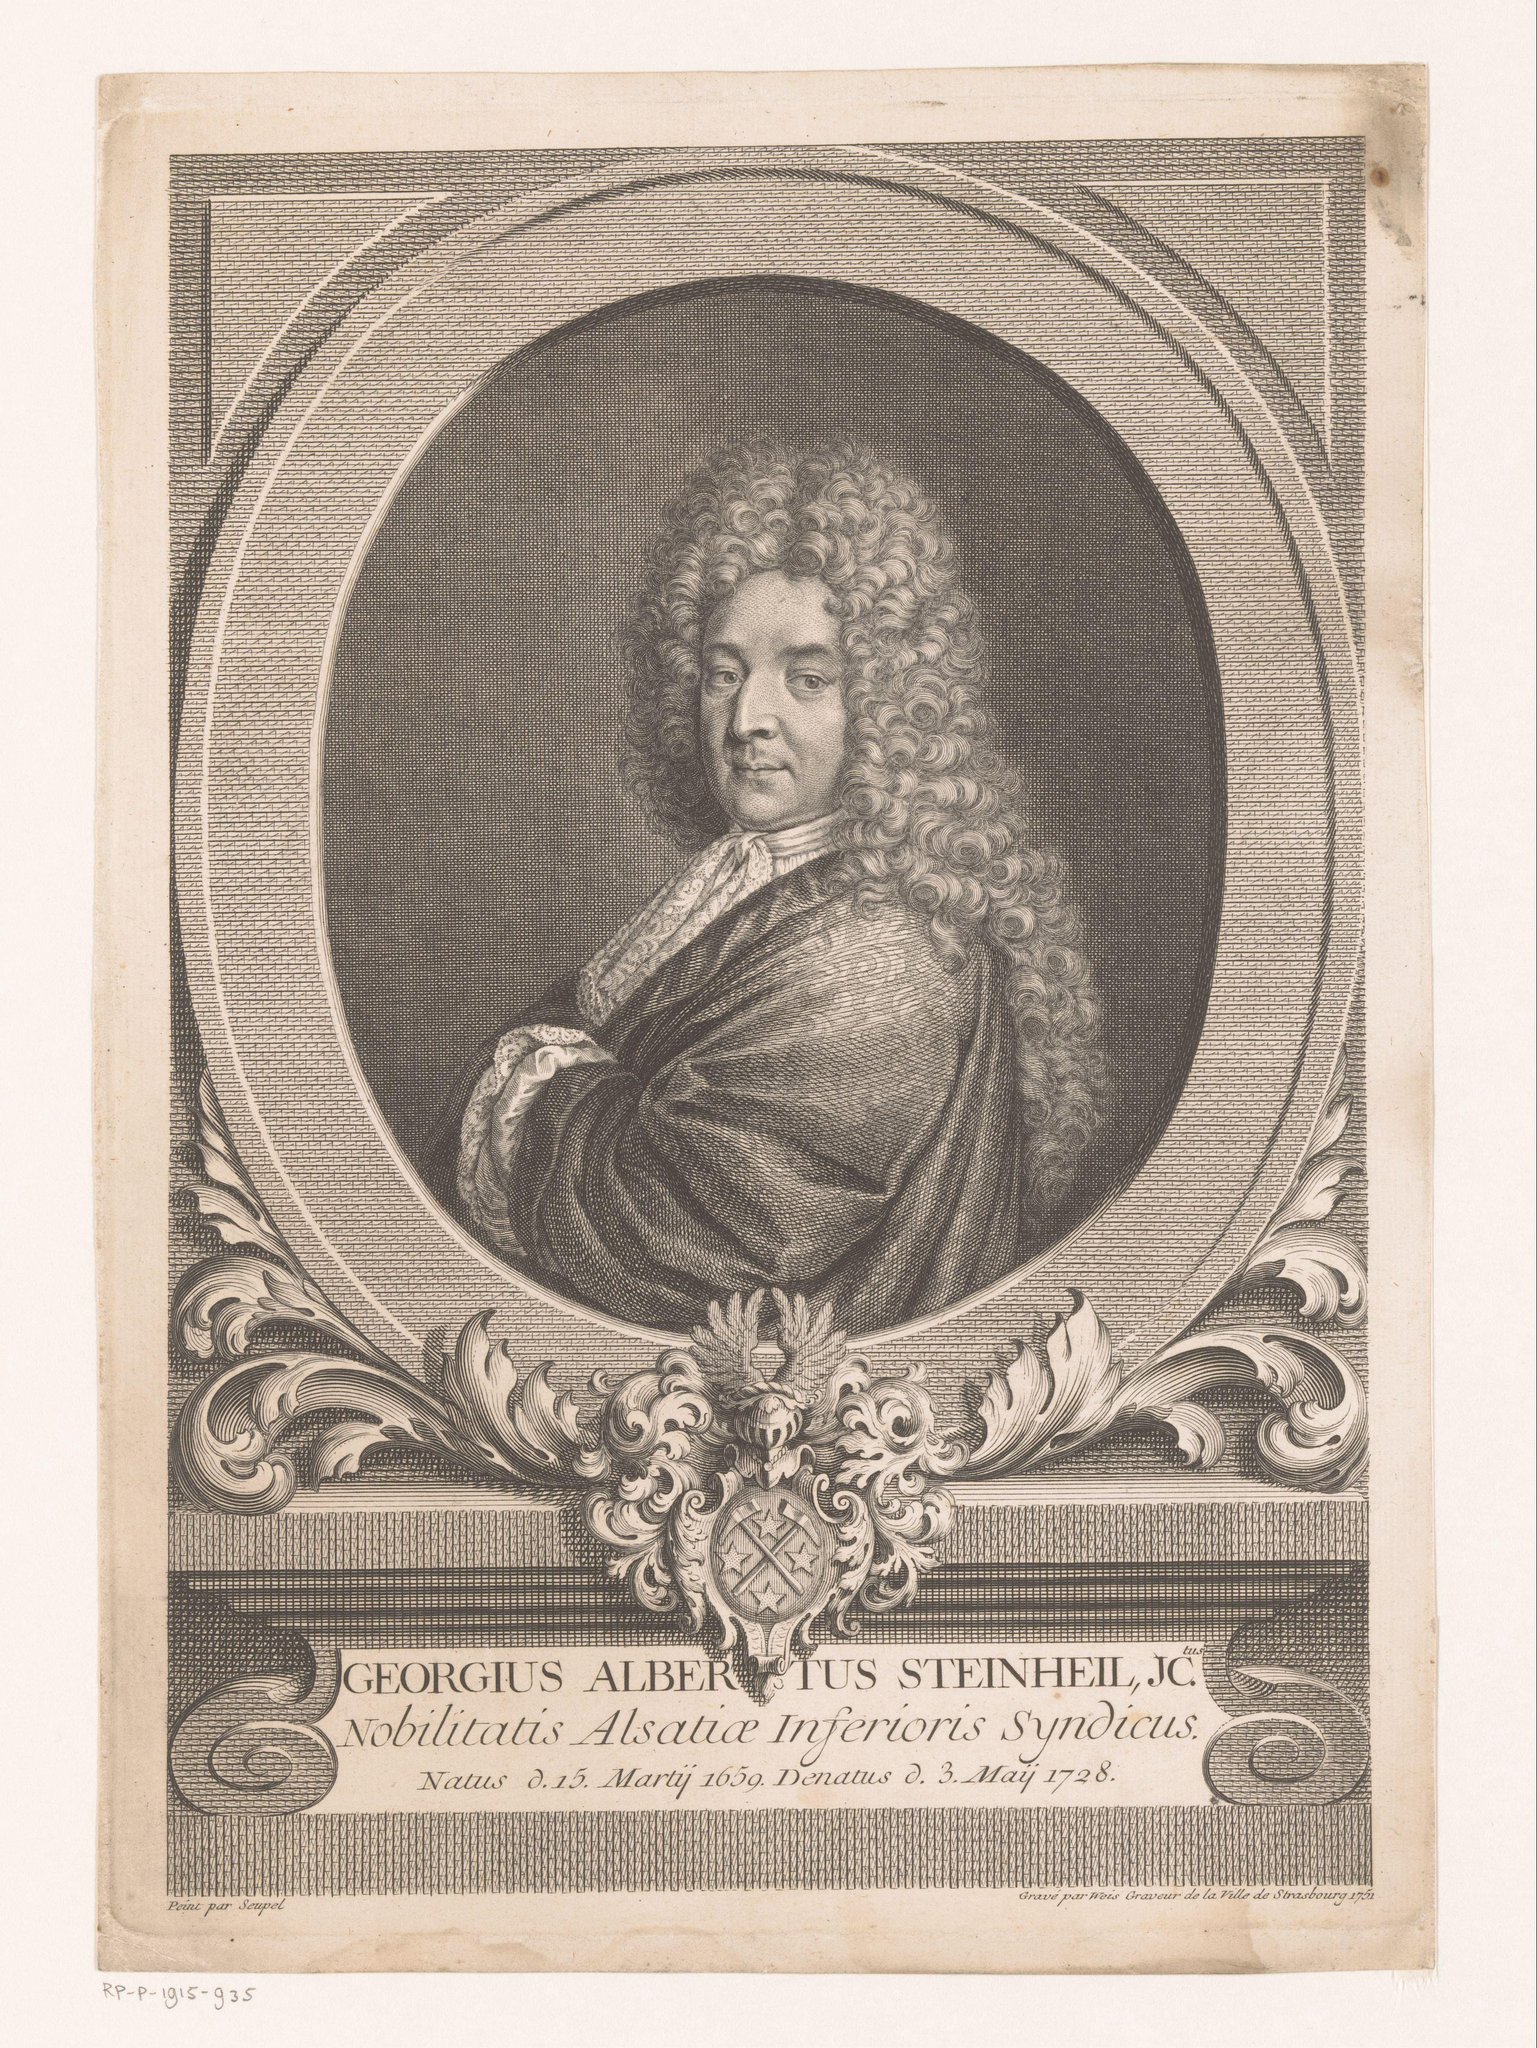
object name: print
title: Portret van George-Albert Steinheil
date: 1751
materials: paper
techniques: engraving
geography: straatsburg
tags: historical persons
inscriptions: collector's mark: Lugt 2228